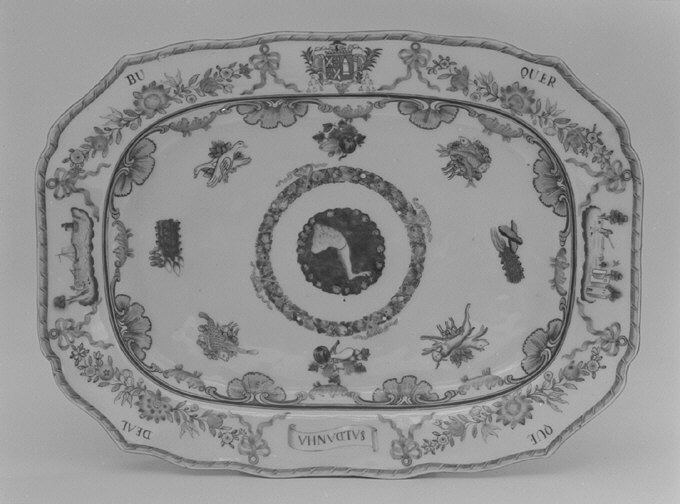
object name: platter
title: Platter (part of a service)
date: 1765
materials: hard paste porcelain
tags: birds,flowers,coat of arms